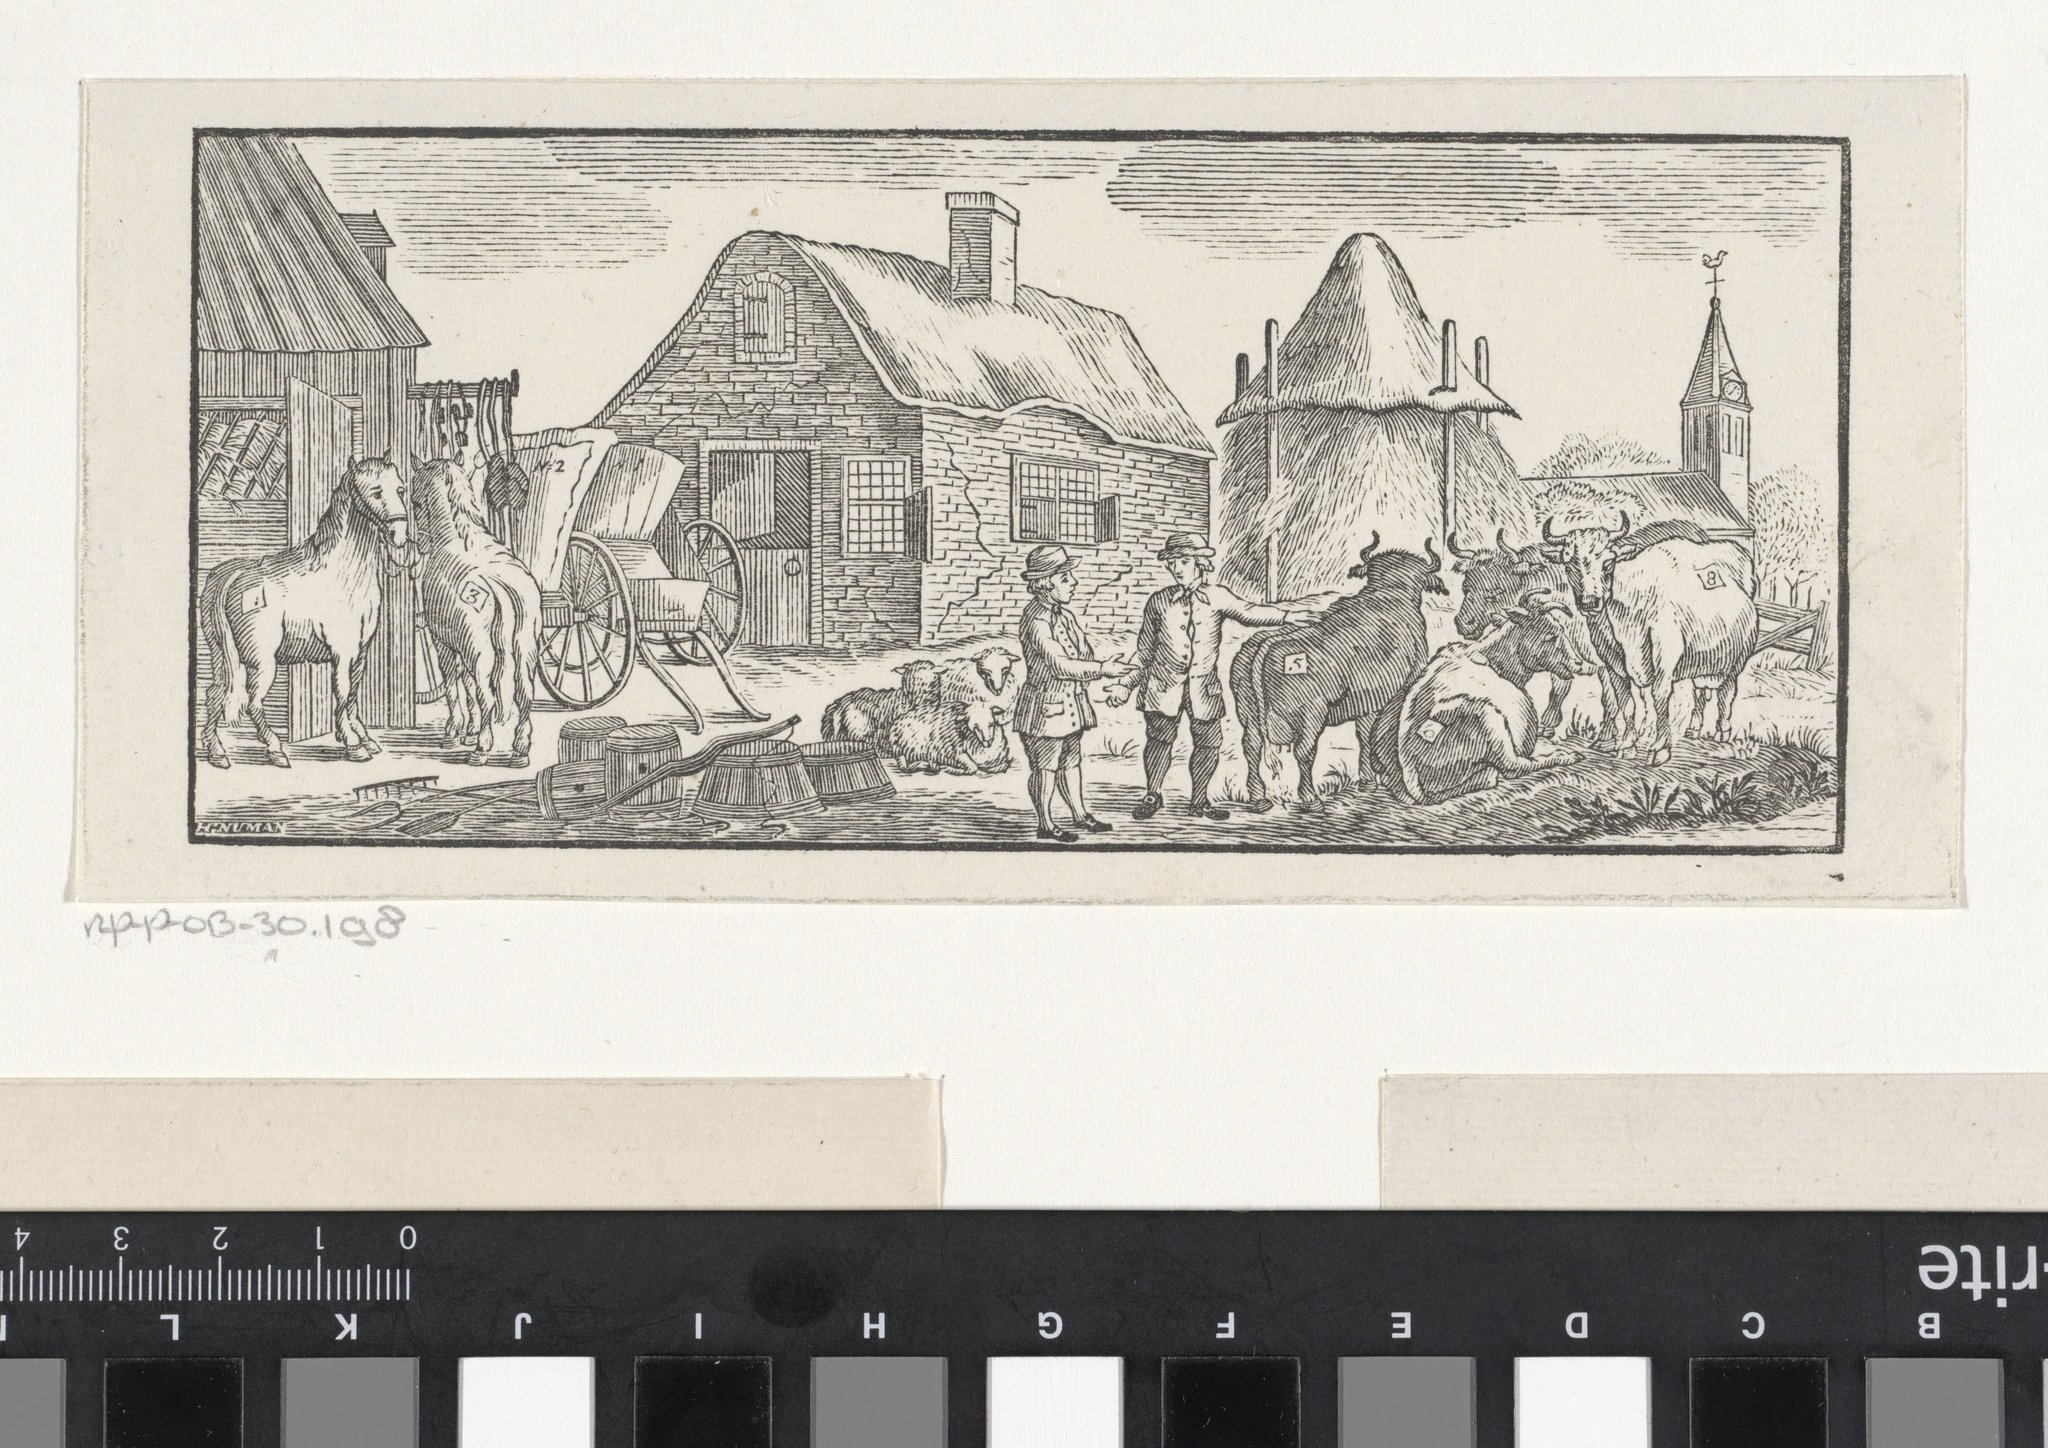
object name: print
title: Veehandel op een boerderij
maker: hendrik numan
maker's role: draughtsman, print maker, publisher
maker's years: 1736-1788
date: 1746-1788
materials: paper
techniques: woodcut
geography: haarlem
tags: cow, sheep, horse, cattle-breeding, livestock industry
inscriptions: collector's mark: Lugt 240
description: Op een boerderij staan twee mannen tussen een aantal genummerde koeien, paarden en schapen.